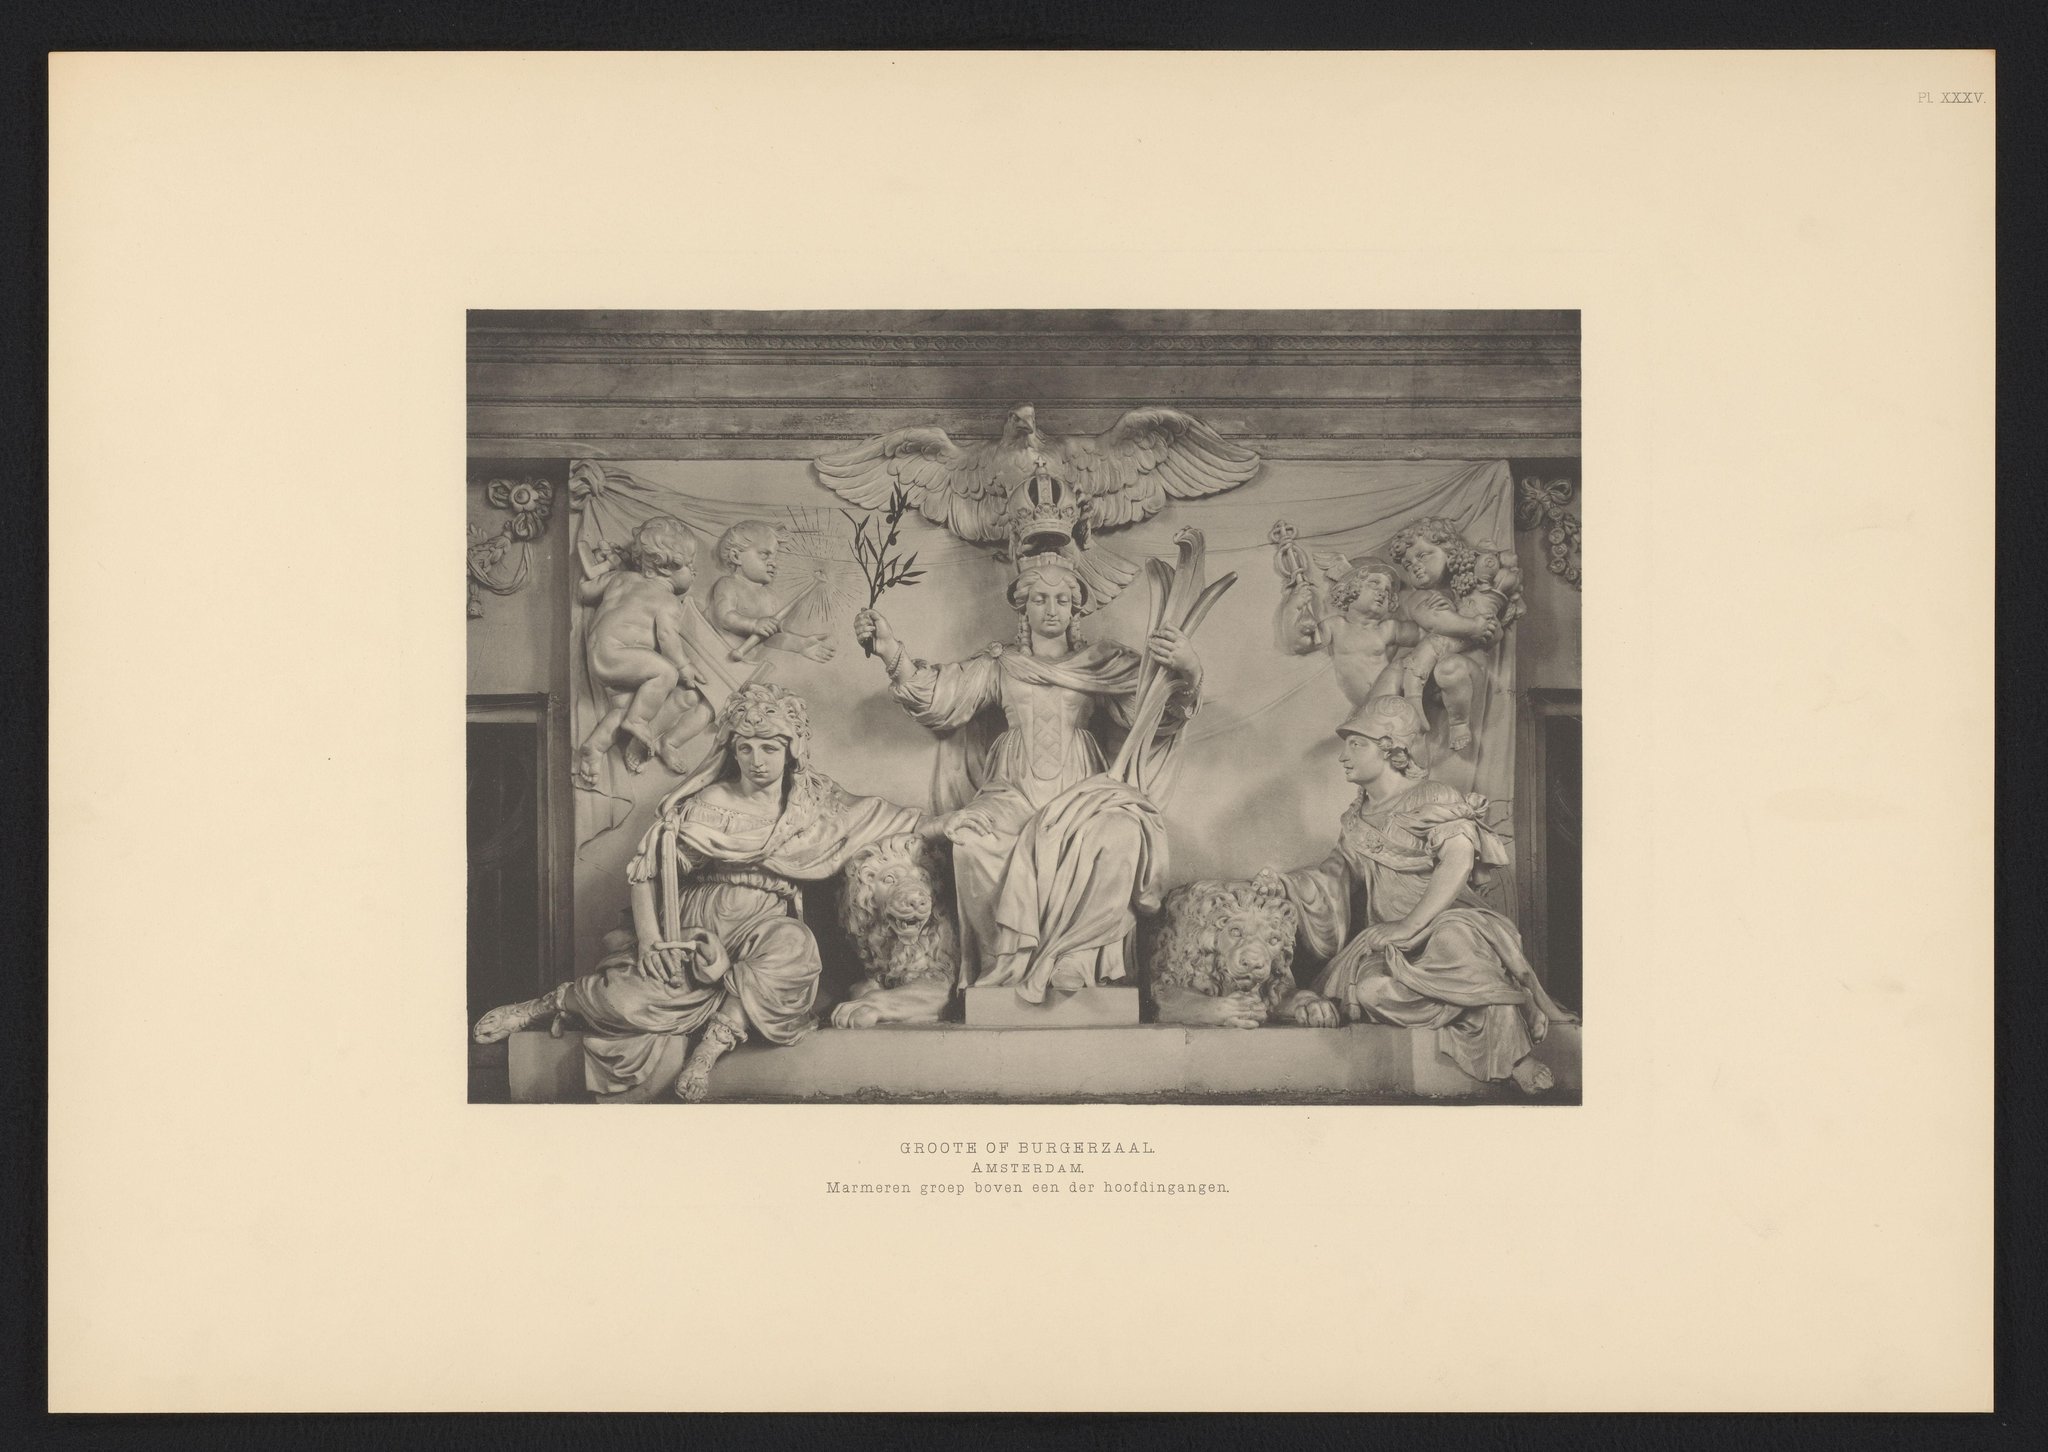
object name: photograph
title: Sculptuur personficatie van Amsterdam in de Burgerzaal, Paleis op de Dam, Amsterdam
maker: Anonymous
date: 1899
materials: cardboard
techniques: photograph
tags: palace, piece of sculpture, reproduction of a piece of sculpture, interior of the house, royal palace of amsterdam, amsterdam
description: Groote of Burgerzaal. Amsterdam. Marmeren groep boven een der hoofdingangen.